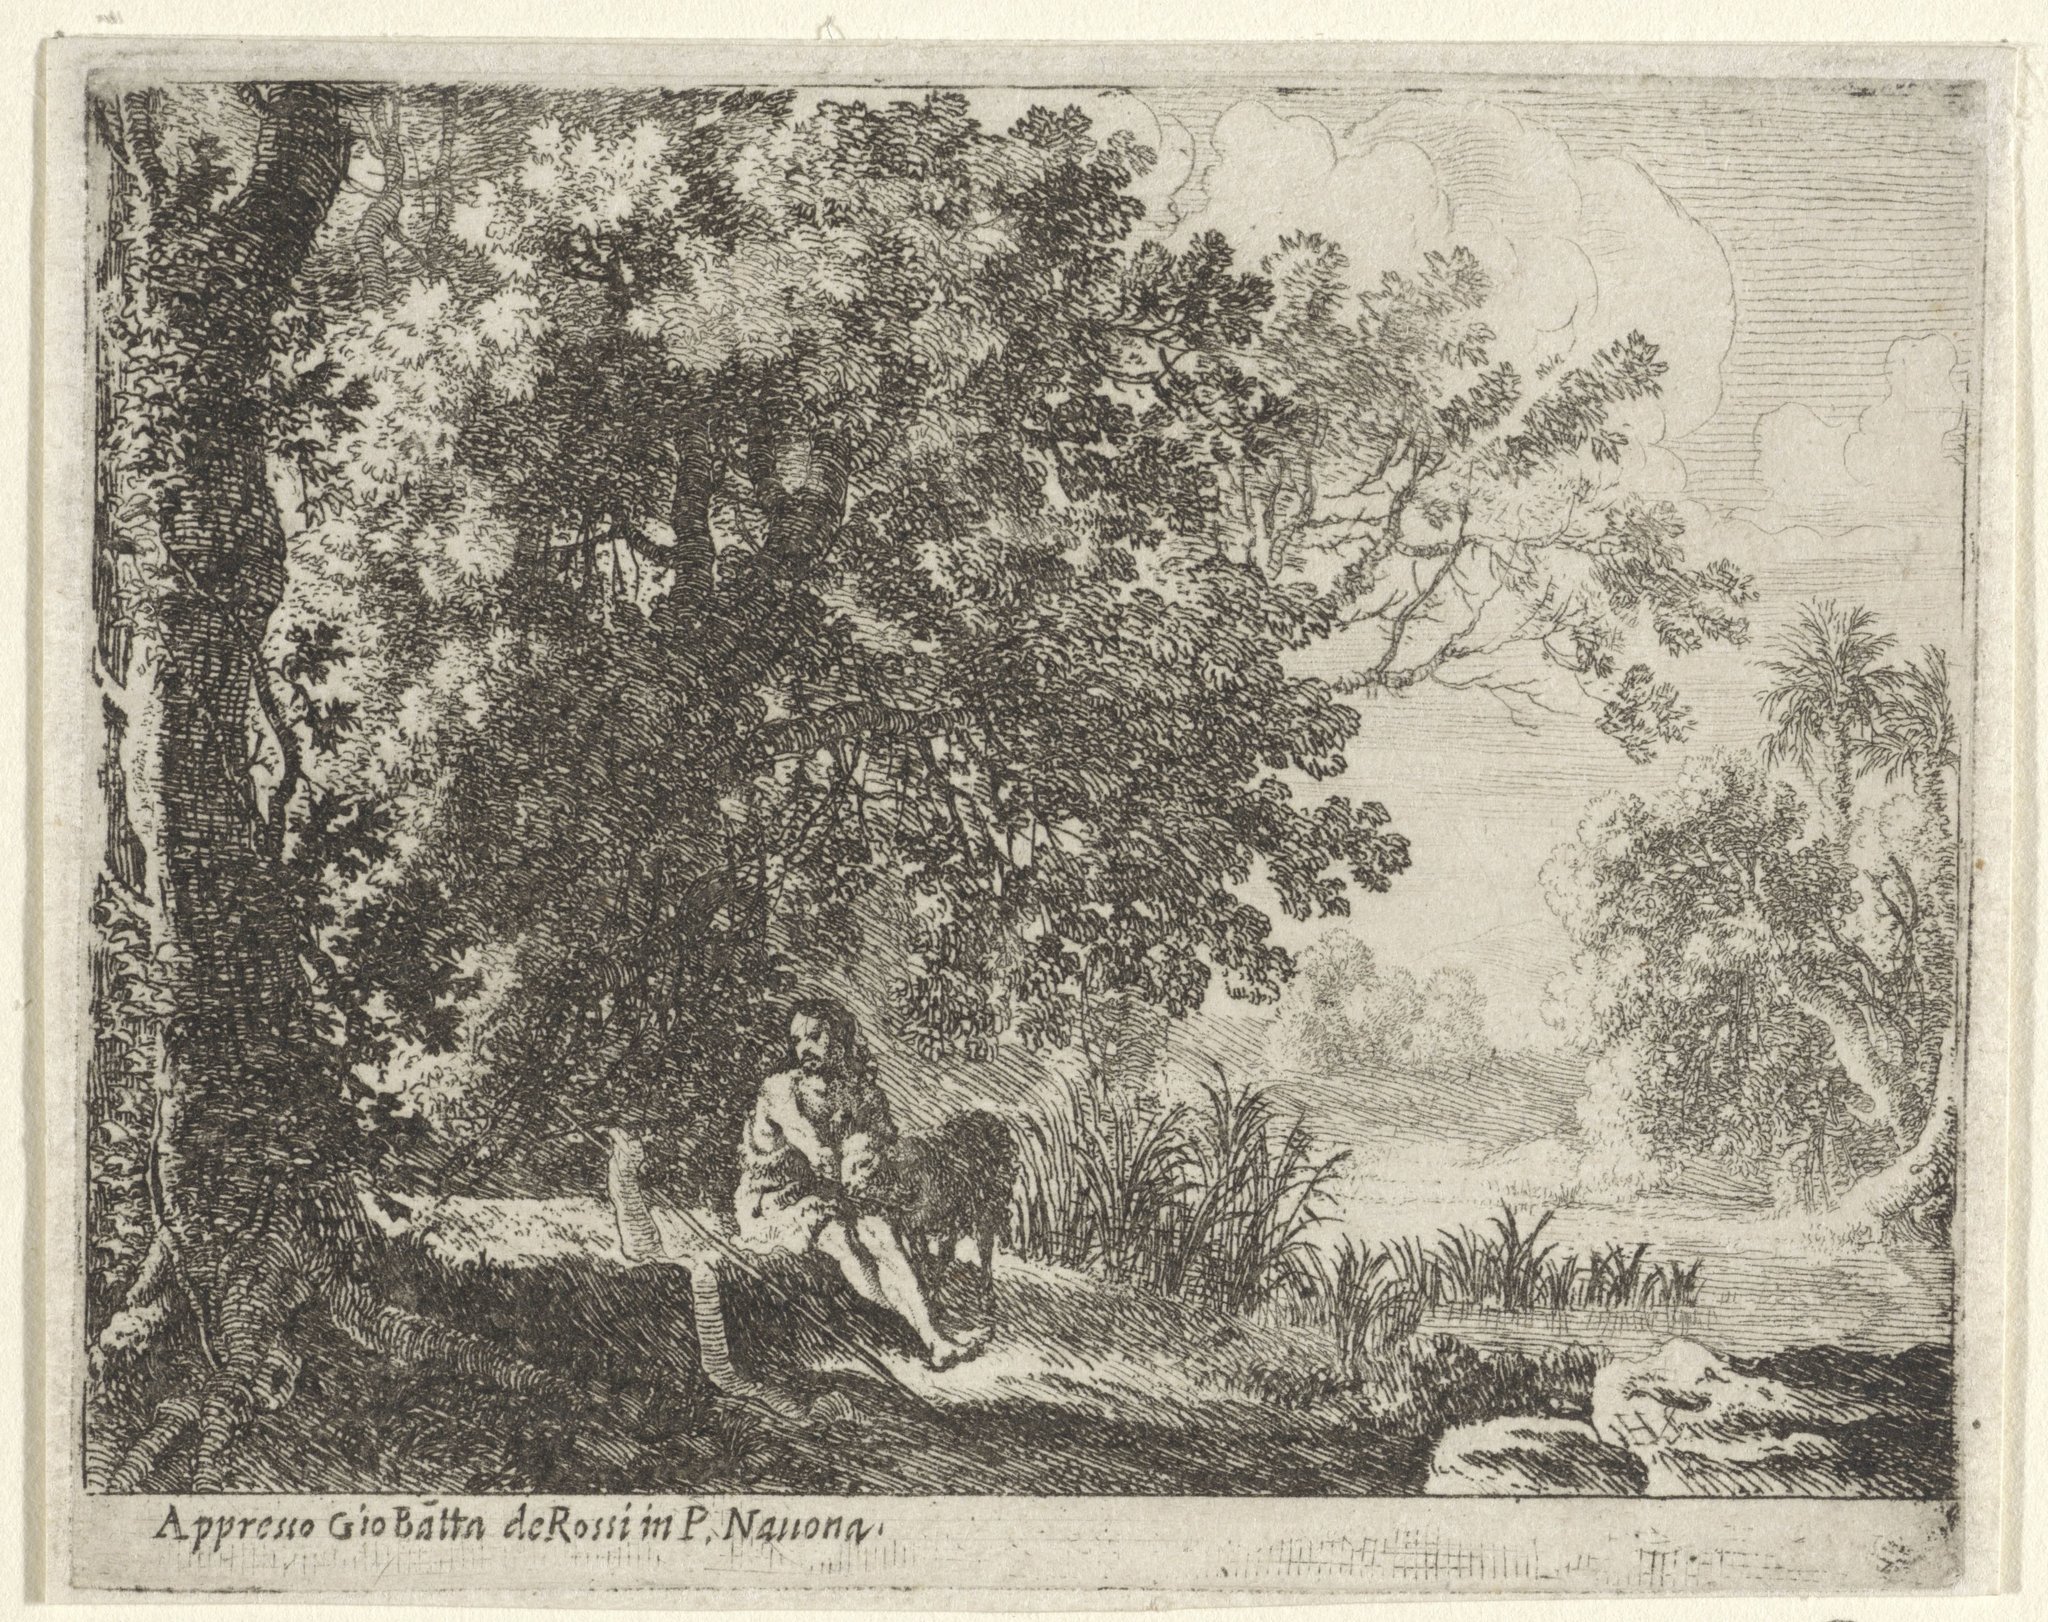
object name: print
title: Johannes de Doper in de wildernis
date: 1629-1641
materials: paper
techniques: etching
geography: rome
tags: john the baptist in the wilderness, usually accompanied by a lamb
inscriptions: collector's mark: ‘KONING: BIBLIO:’ Lugt 240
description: Johannes de Doper zit aan de oever van een rivier. Hij wordt geflankeerd door zijn attributen, een houten kruis en een lam.